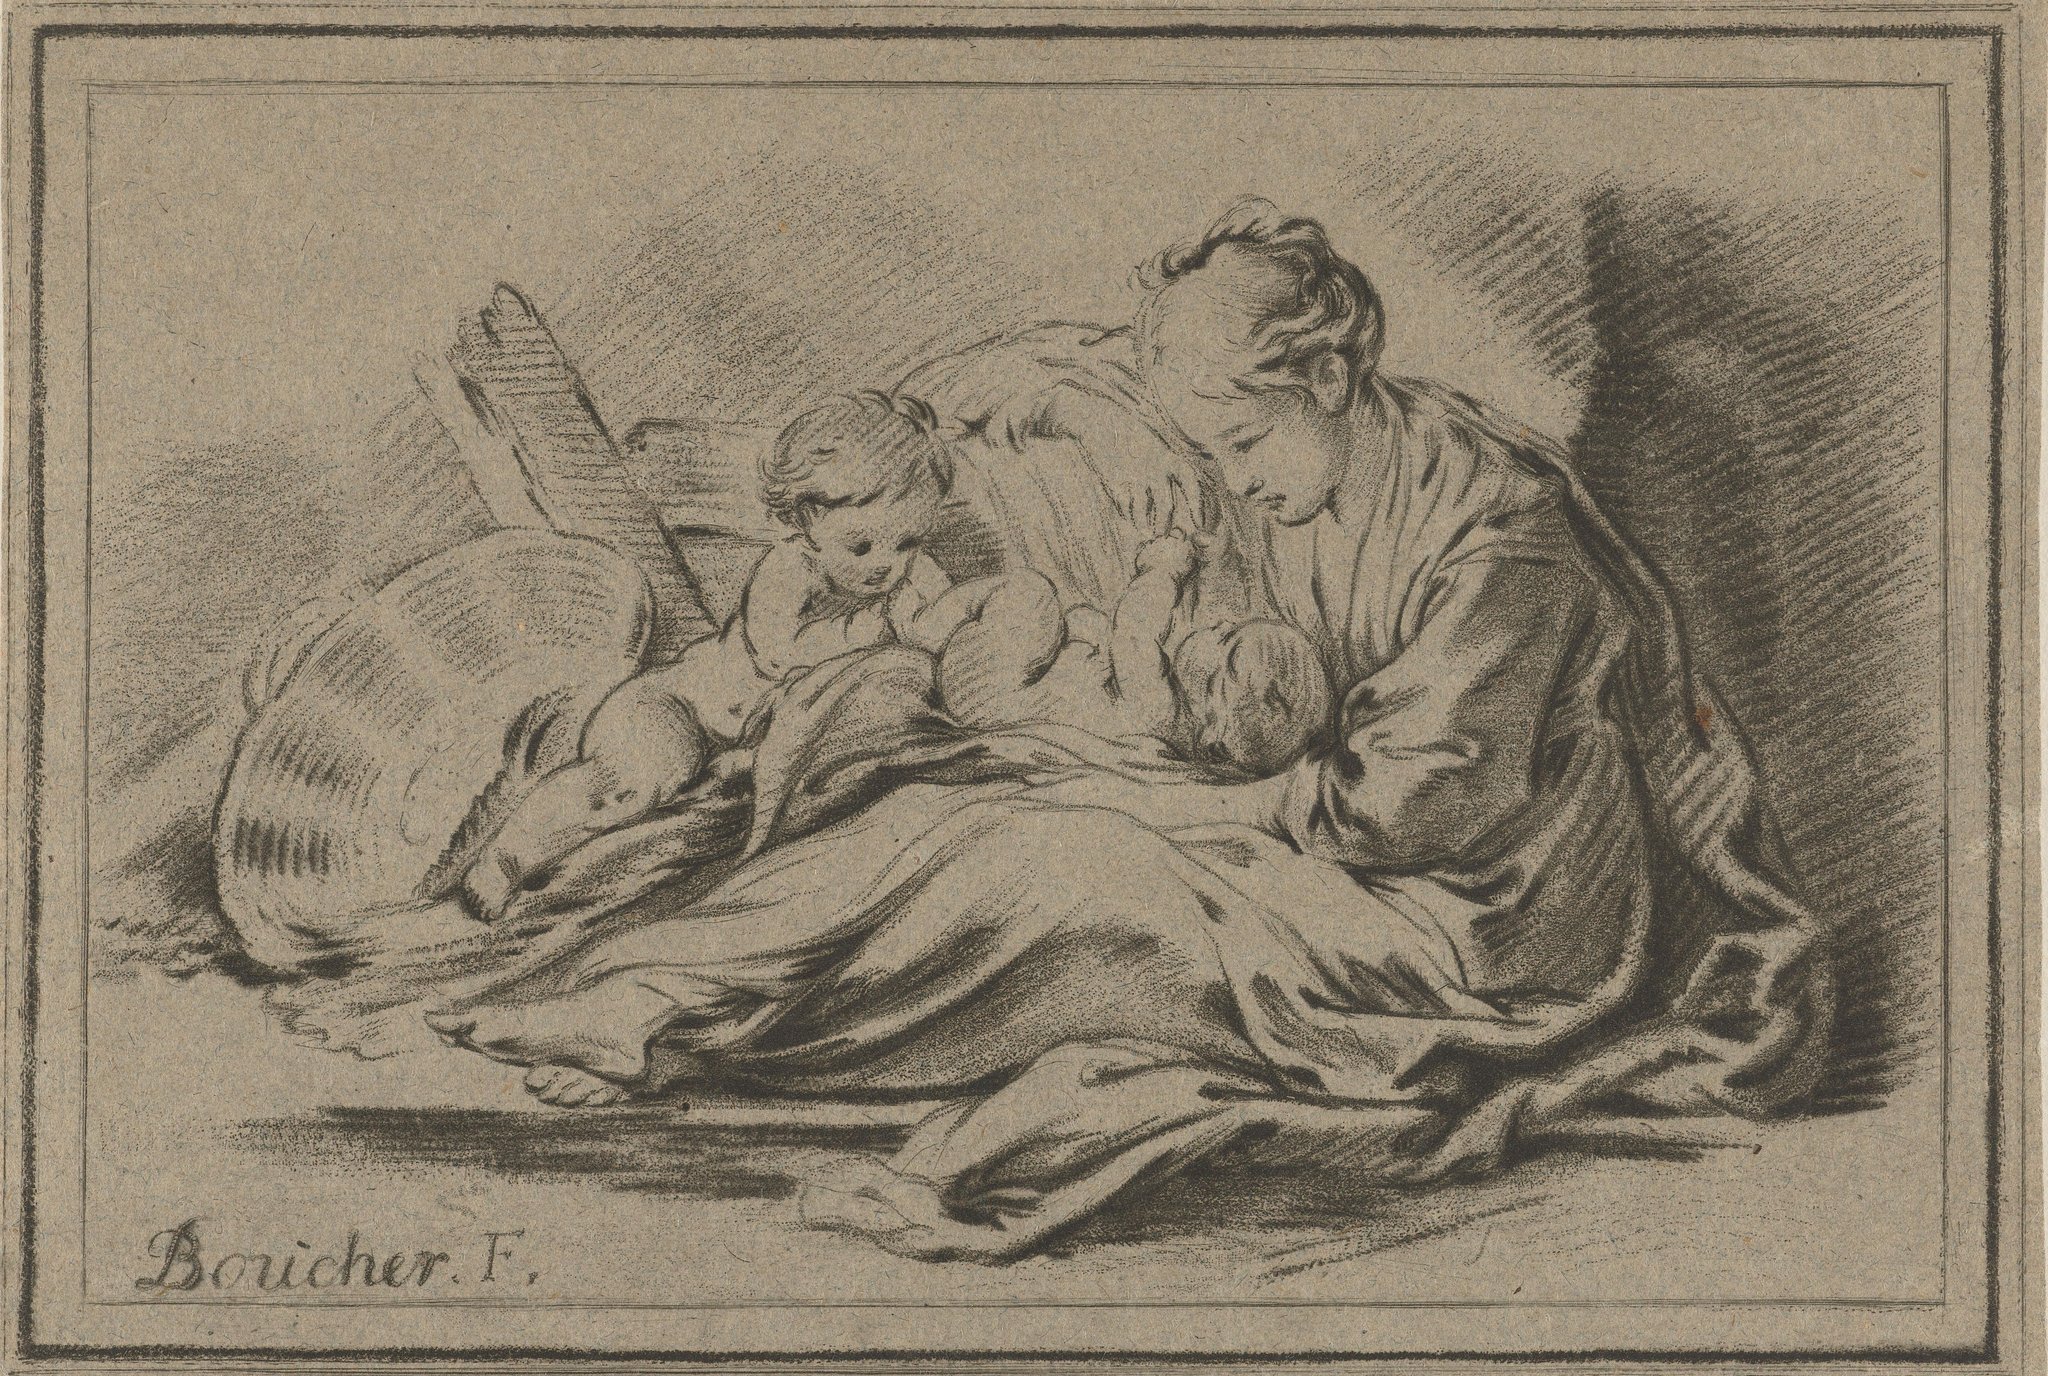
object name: print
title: Moeder en twee kinderen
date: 1724-1798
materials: paper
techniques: printmaking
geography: amsterdam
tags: mother and baby or young child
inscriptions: collector's mark: Lugt 2760, collector's mark: Lugt 2228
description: Een moeder zit op de grond naast een mand en houdt een baby in haar armen. Naast haar een ander kind.